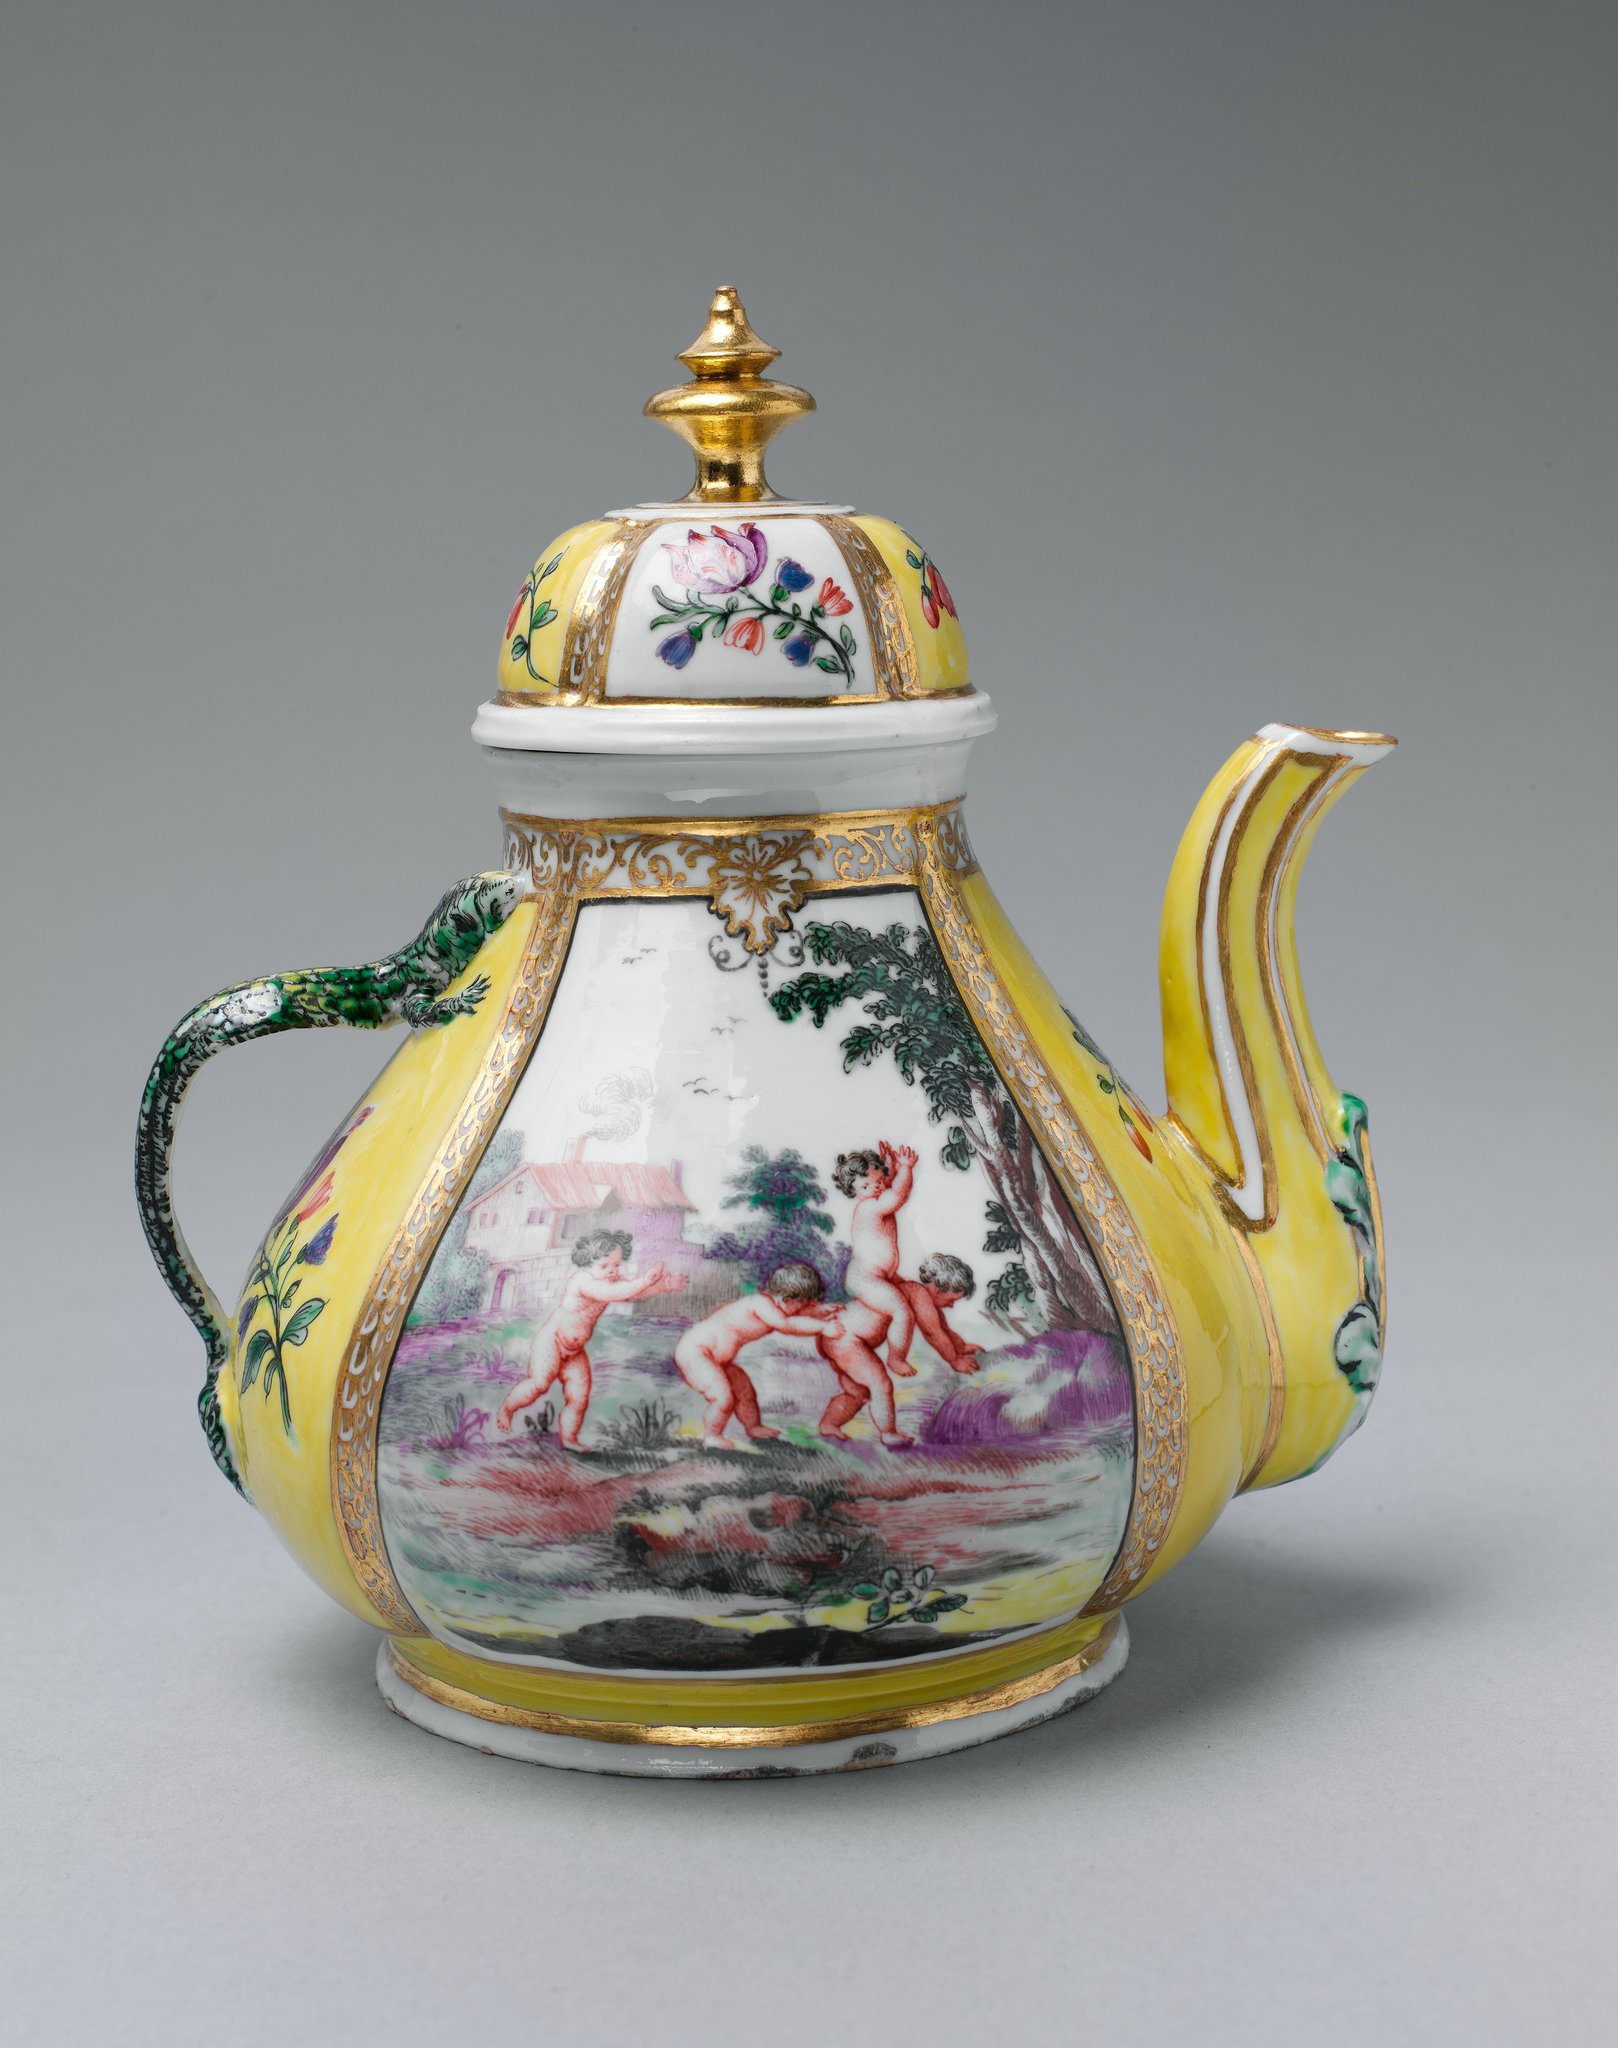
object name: teapot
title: Teapot (part of a service)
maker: doccia porcelain manufactory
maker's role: manufactory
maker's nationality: italian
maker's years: 1737-1896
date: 1750-1755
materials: hard paste porcelain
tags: boys